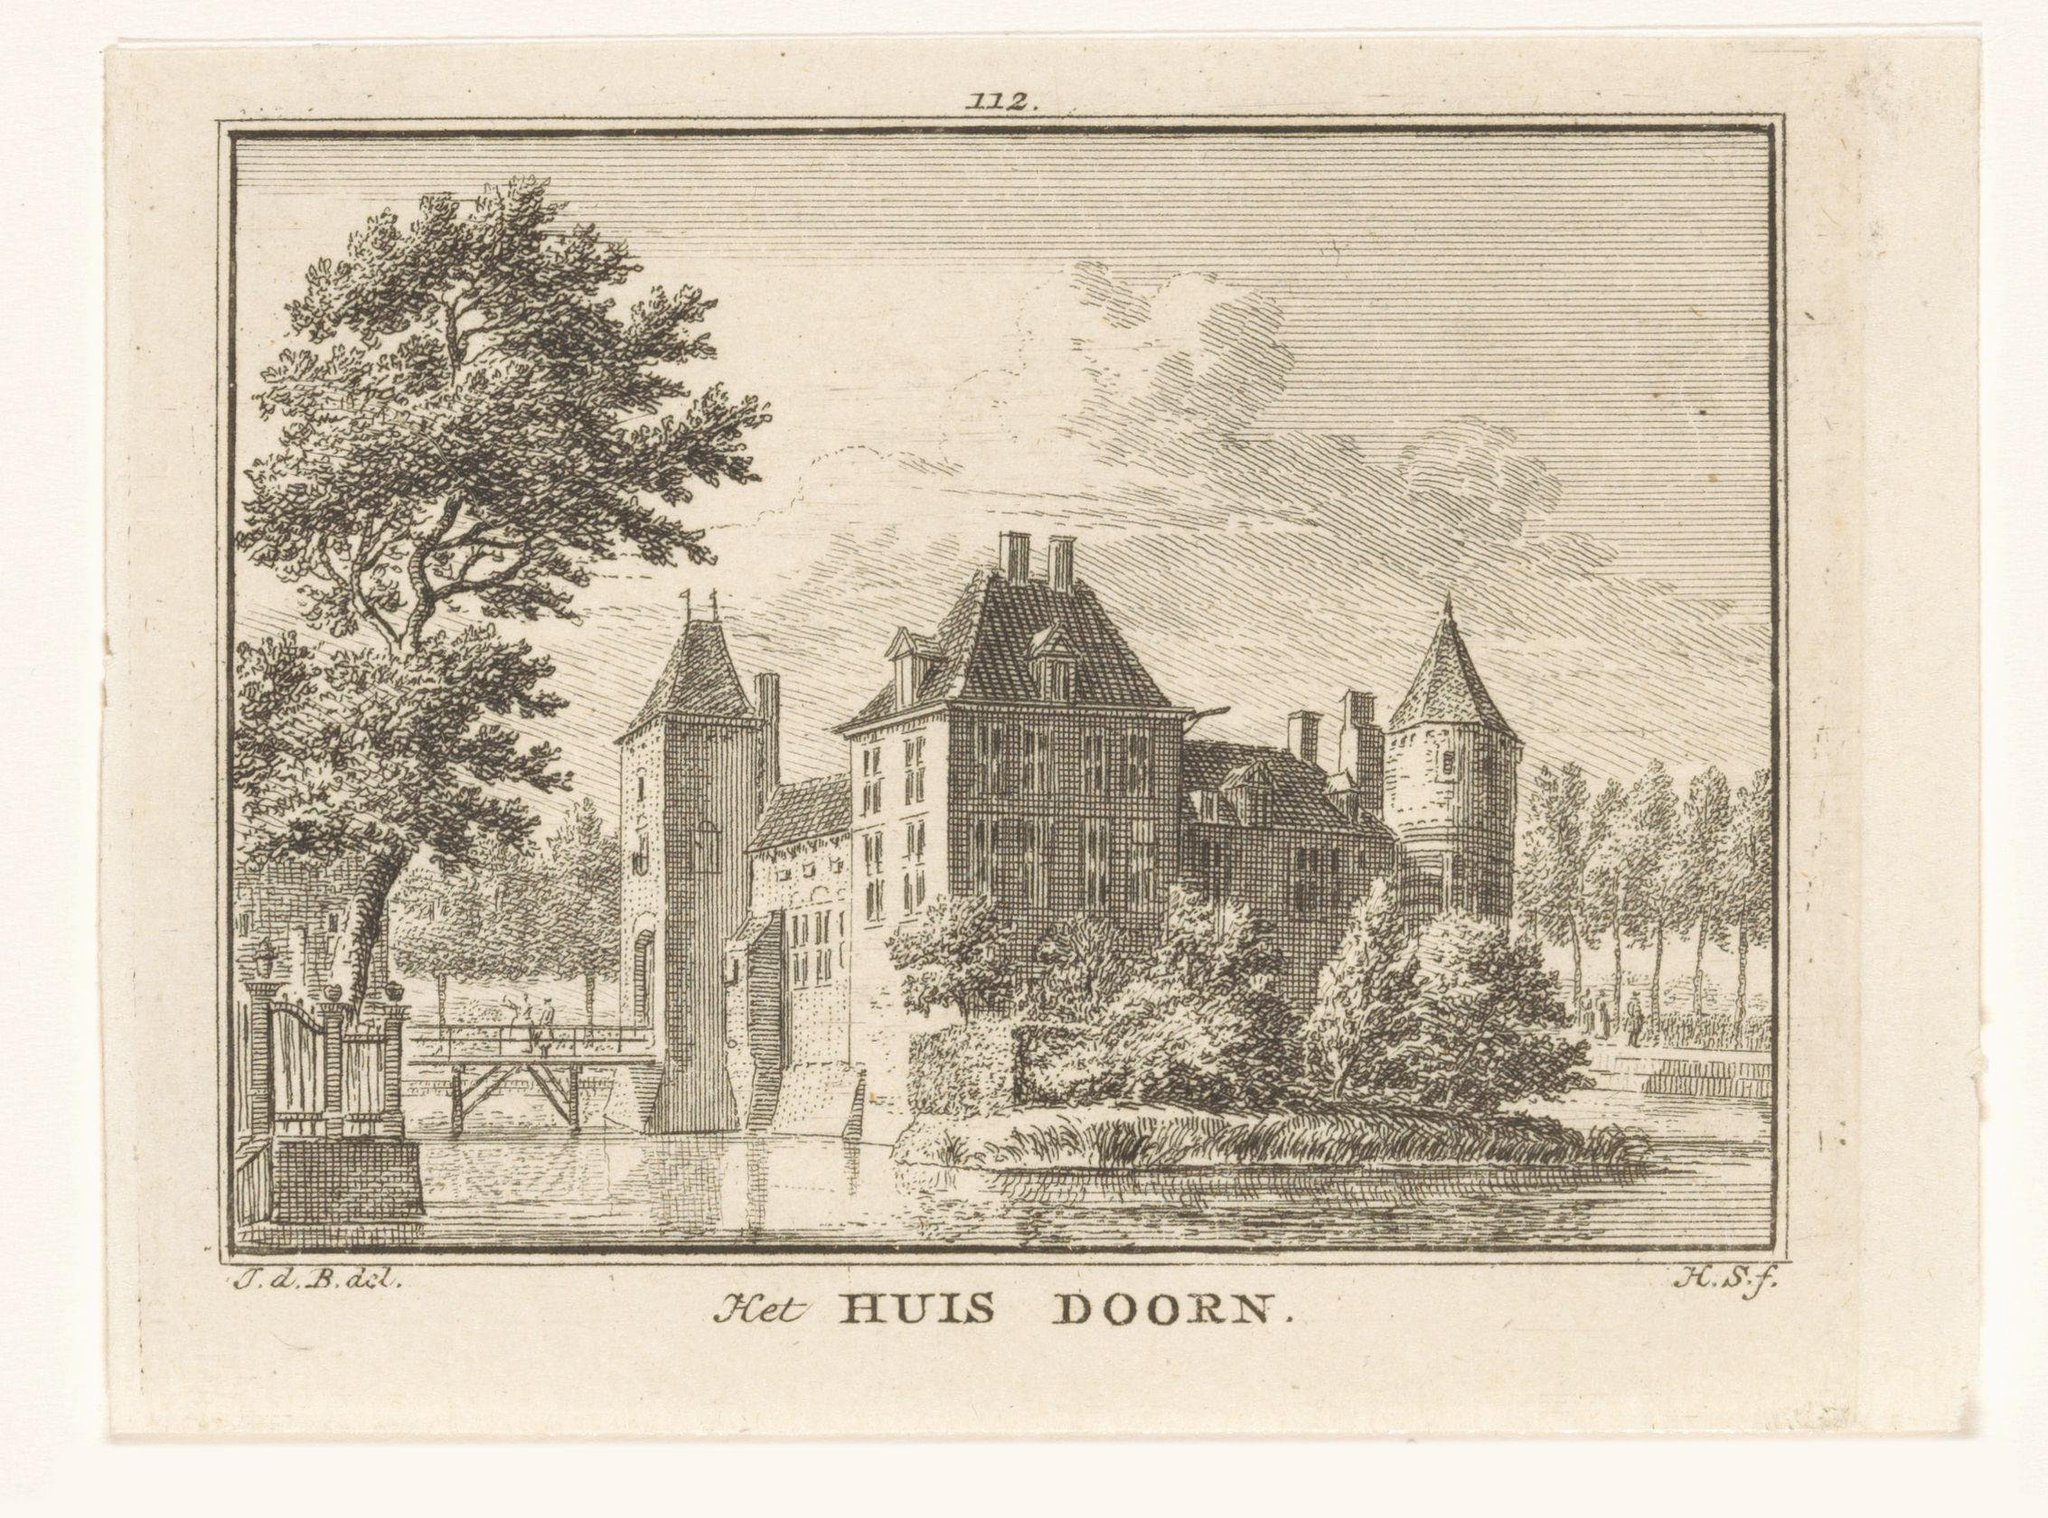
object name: print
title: Het huis Doorn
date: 1773-1792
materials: paper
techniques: engraving, etching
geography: haarlem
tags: castle, bridge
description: Prent ook gebruikt in: Het verheerlykt Nederland of kabinet van hedendaagsche gezigten van steden, dorpen (…). 9 delen. Amsterdam: Isaak Tirion en weduwe Isaak Tirion, 1745-1774, dl. 7, 8 of 9 (weduwe Isaak Tirion, 1773-1774), ill. 112. Of in: Nederlandsche tafereelen; of eene keurige verzameling van negen honderd fraaije gezigten van steden, dorpen, sloten, oudheden (….). 9 delen. Amsterdam: Jan de Groot, 1792, dl. 7, 8 of 9, ill. 112. Uit welke druk het huidige exemplaar precies komt is niet na te gaan.